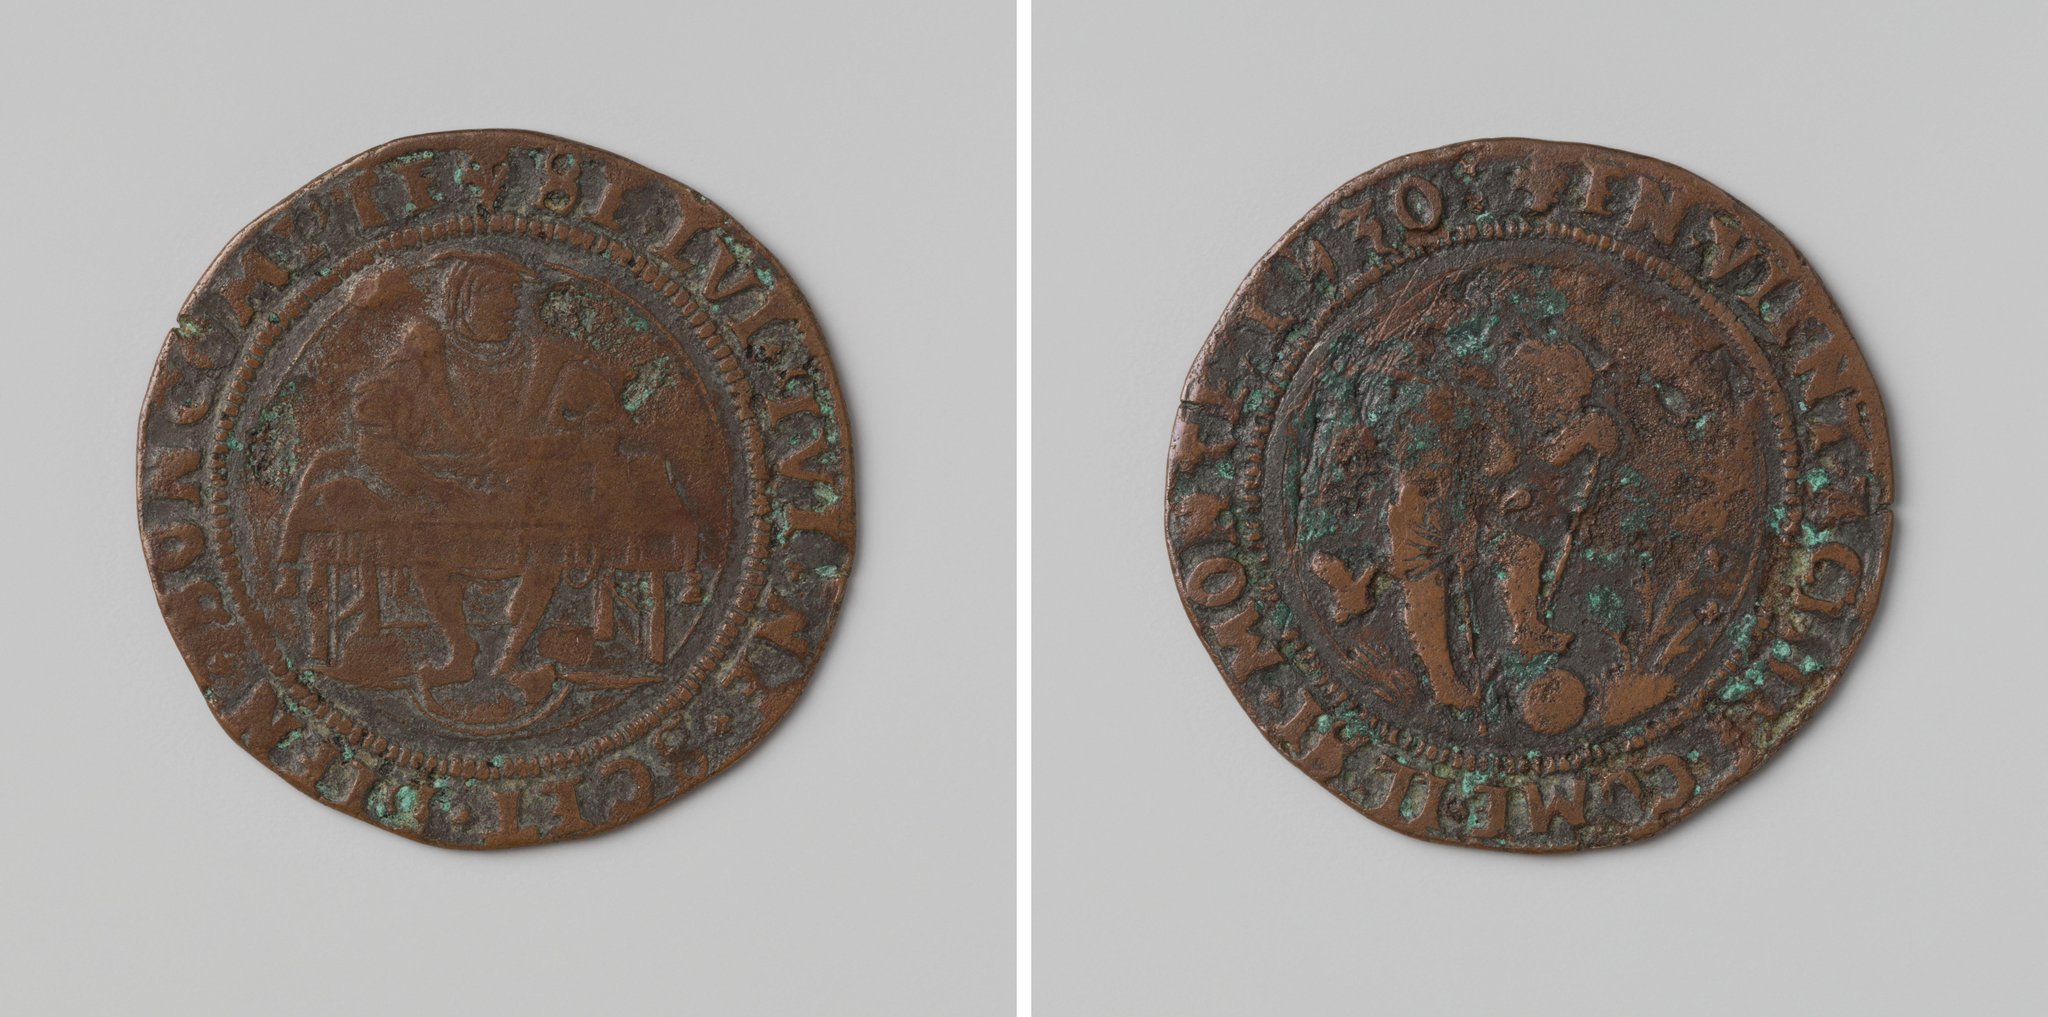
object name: jeton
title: Herstel van de rust in de Nederlanden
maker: Anonymous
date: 1530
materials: copper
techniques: striking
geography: netherlands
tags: frans i van valois-angoulême (koning van frankrijk), low countries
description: Koperen penning. Voorzijde: man, zittend aan tafel, bezig met tellen van geld of rekenpenningen binnen . Keerzijde: genius, bezig met spitten binnen omschrift